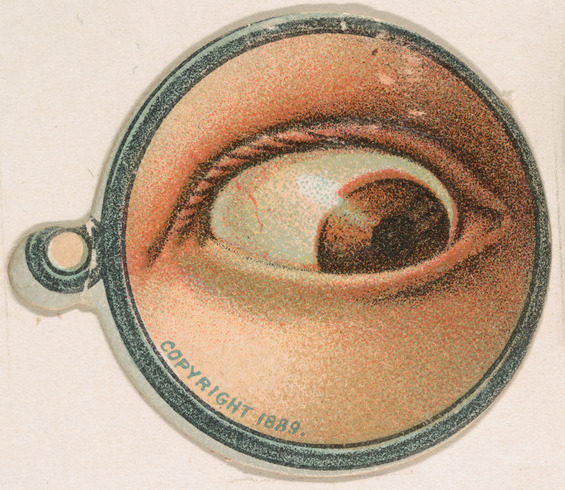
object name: print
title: Monocle and Eye (brown), from Jocular Ocular series (N221) issued by Kinney Bros.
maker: kinney brothers tobacco company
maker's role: publisher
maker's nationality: american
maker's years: 1869-2011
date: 1889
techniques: color lithograph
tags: eyes